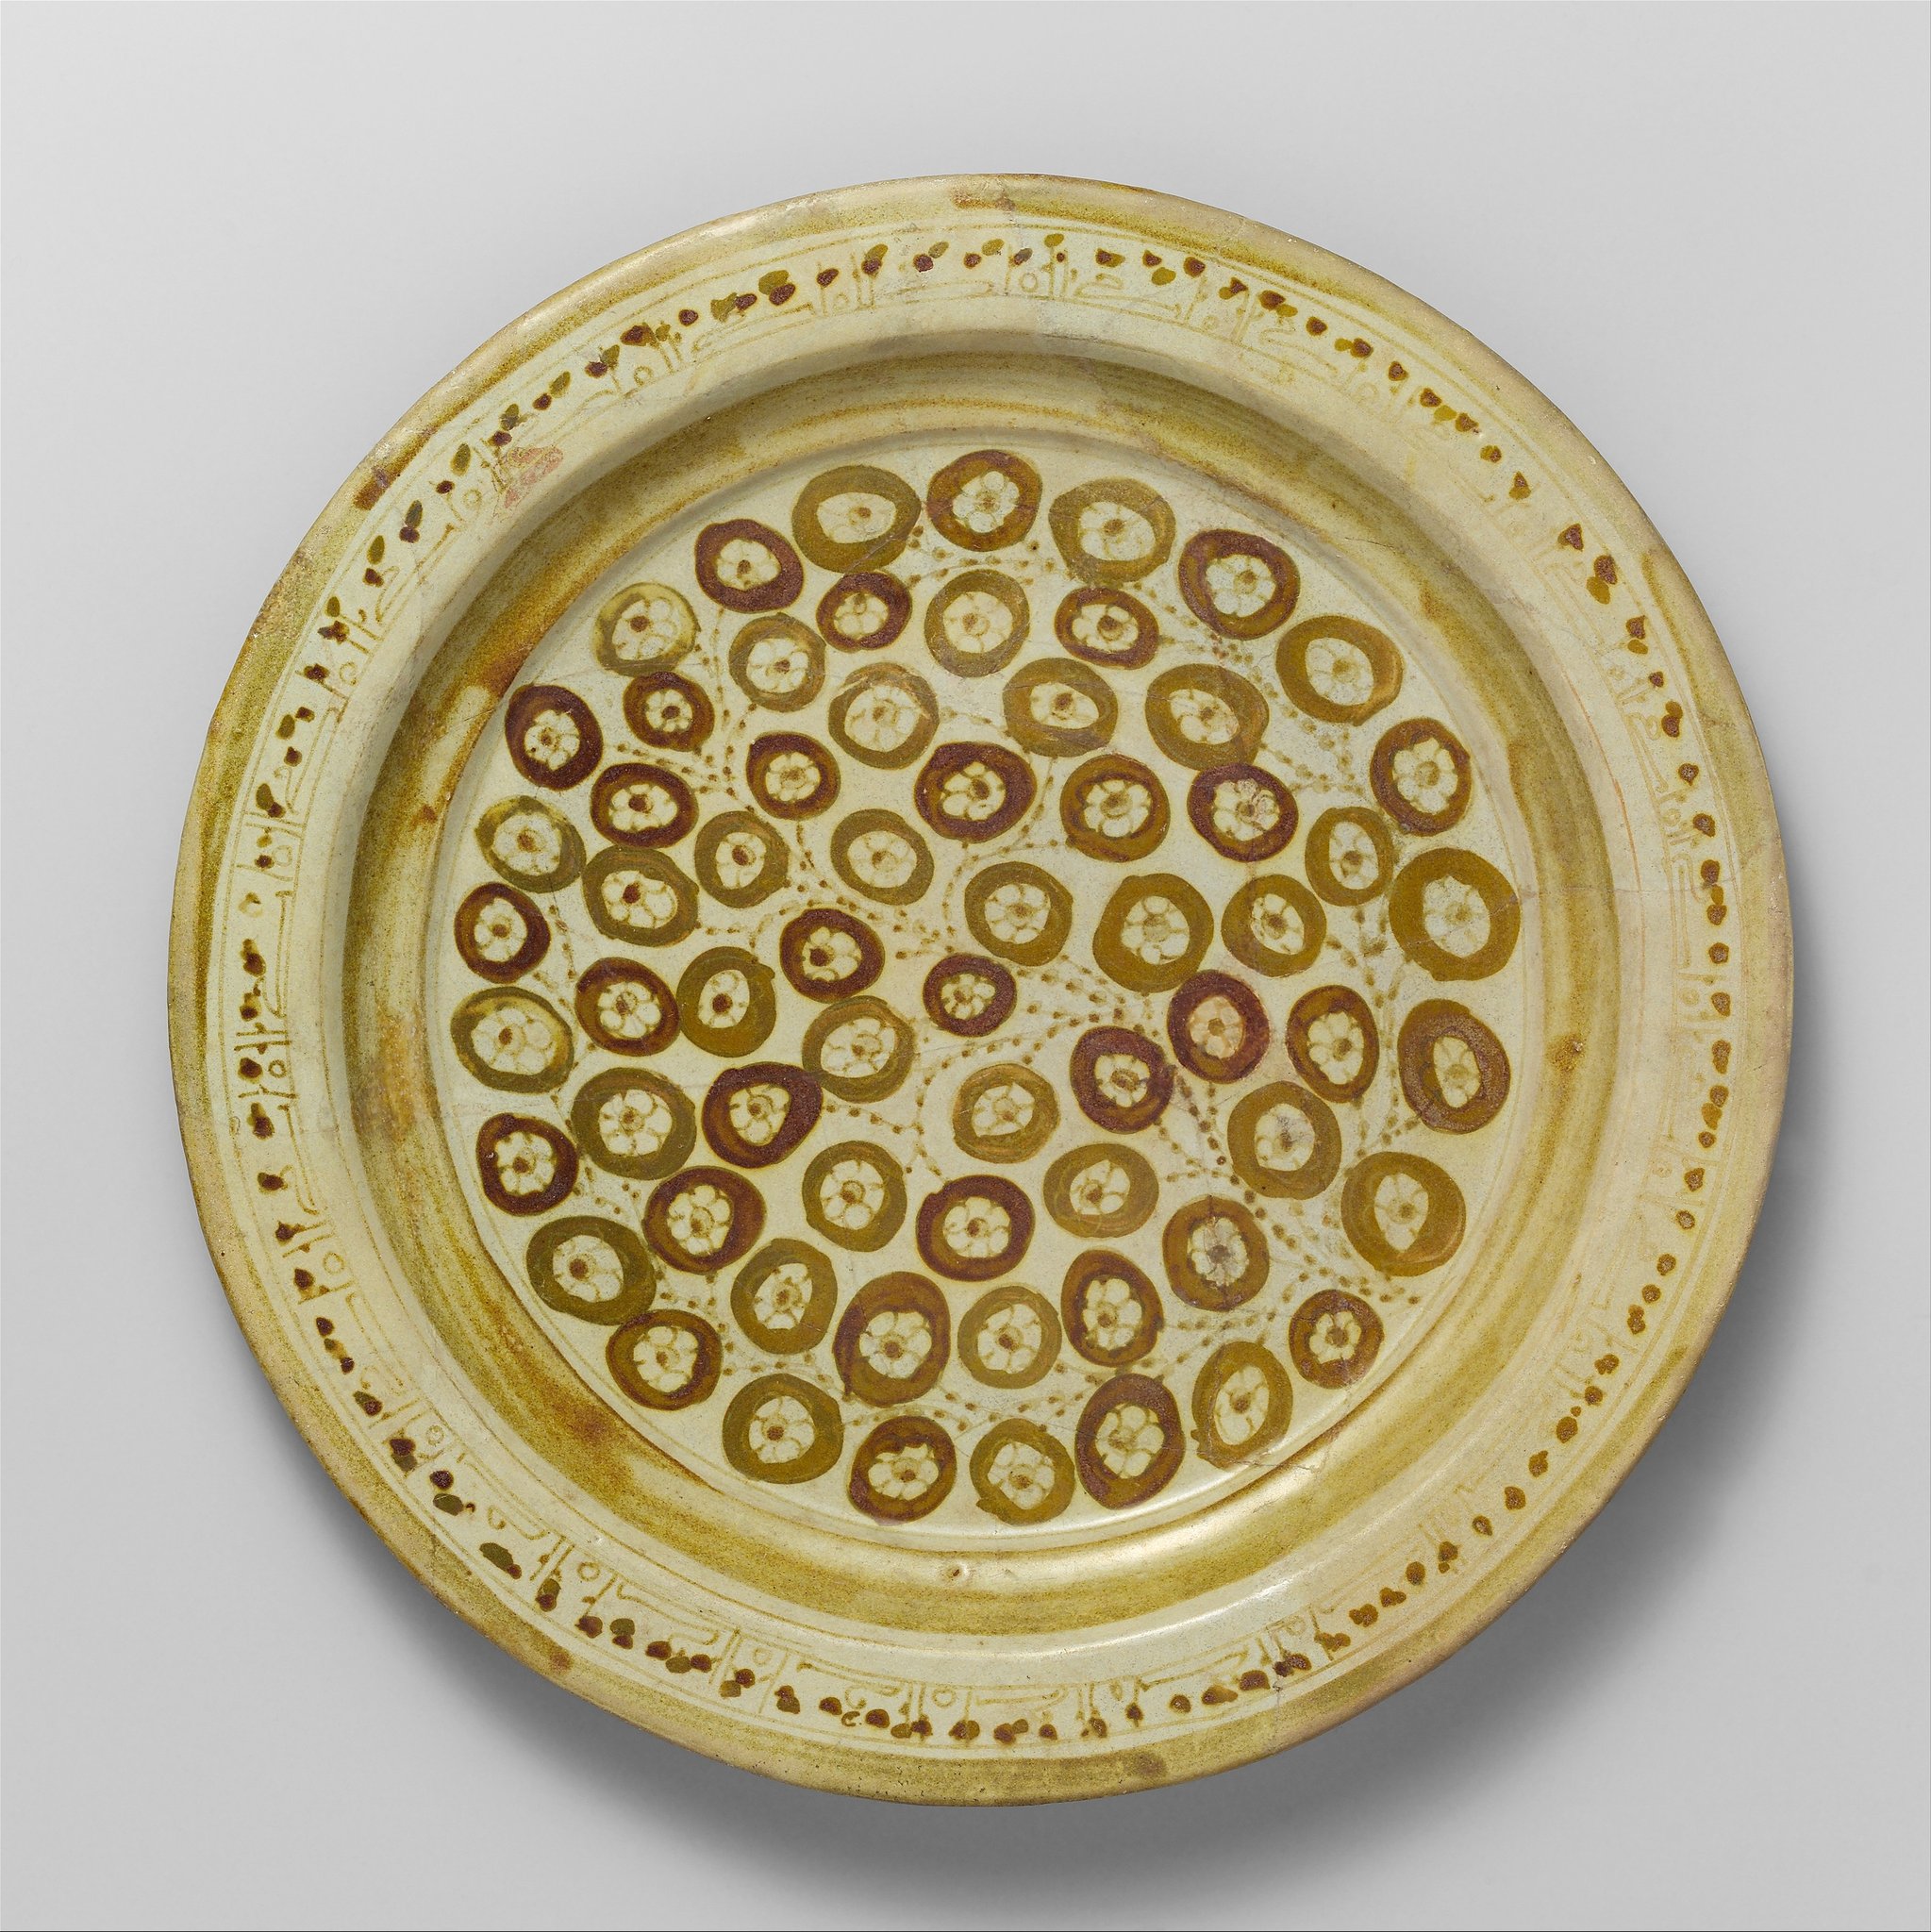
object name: plate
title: Plate Depicting a Flowering Bush in Two-Toned Luster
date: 801-900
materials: earthenware, glaze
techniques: luster painting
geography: iraq